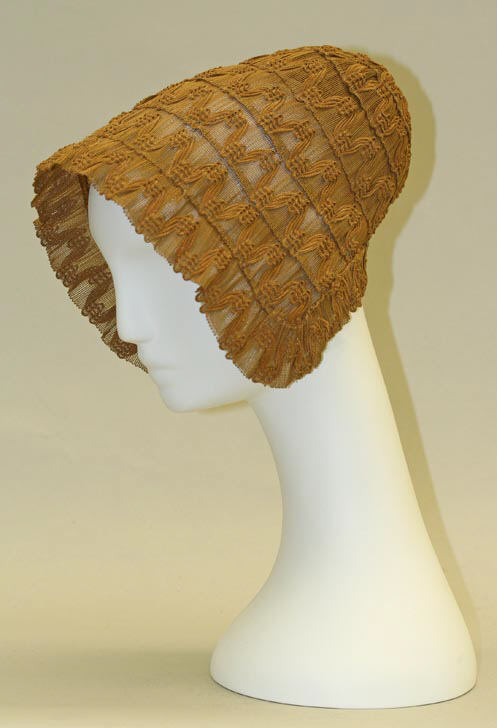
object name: hat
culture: american or european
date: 1830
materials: silk, fiber